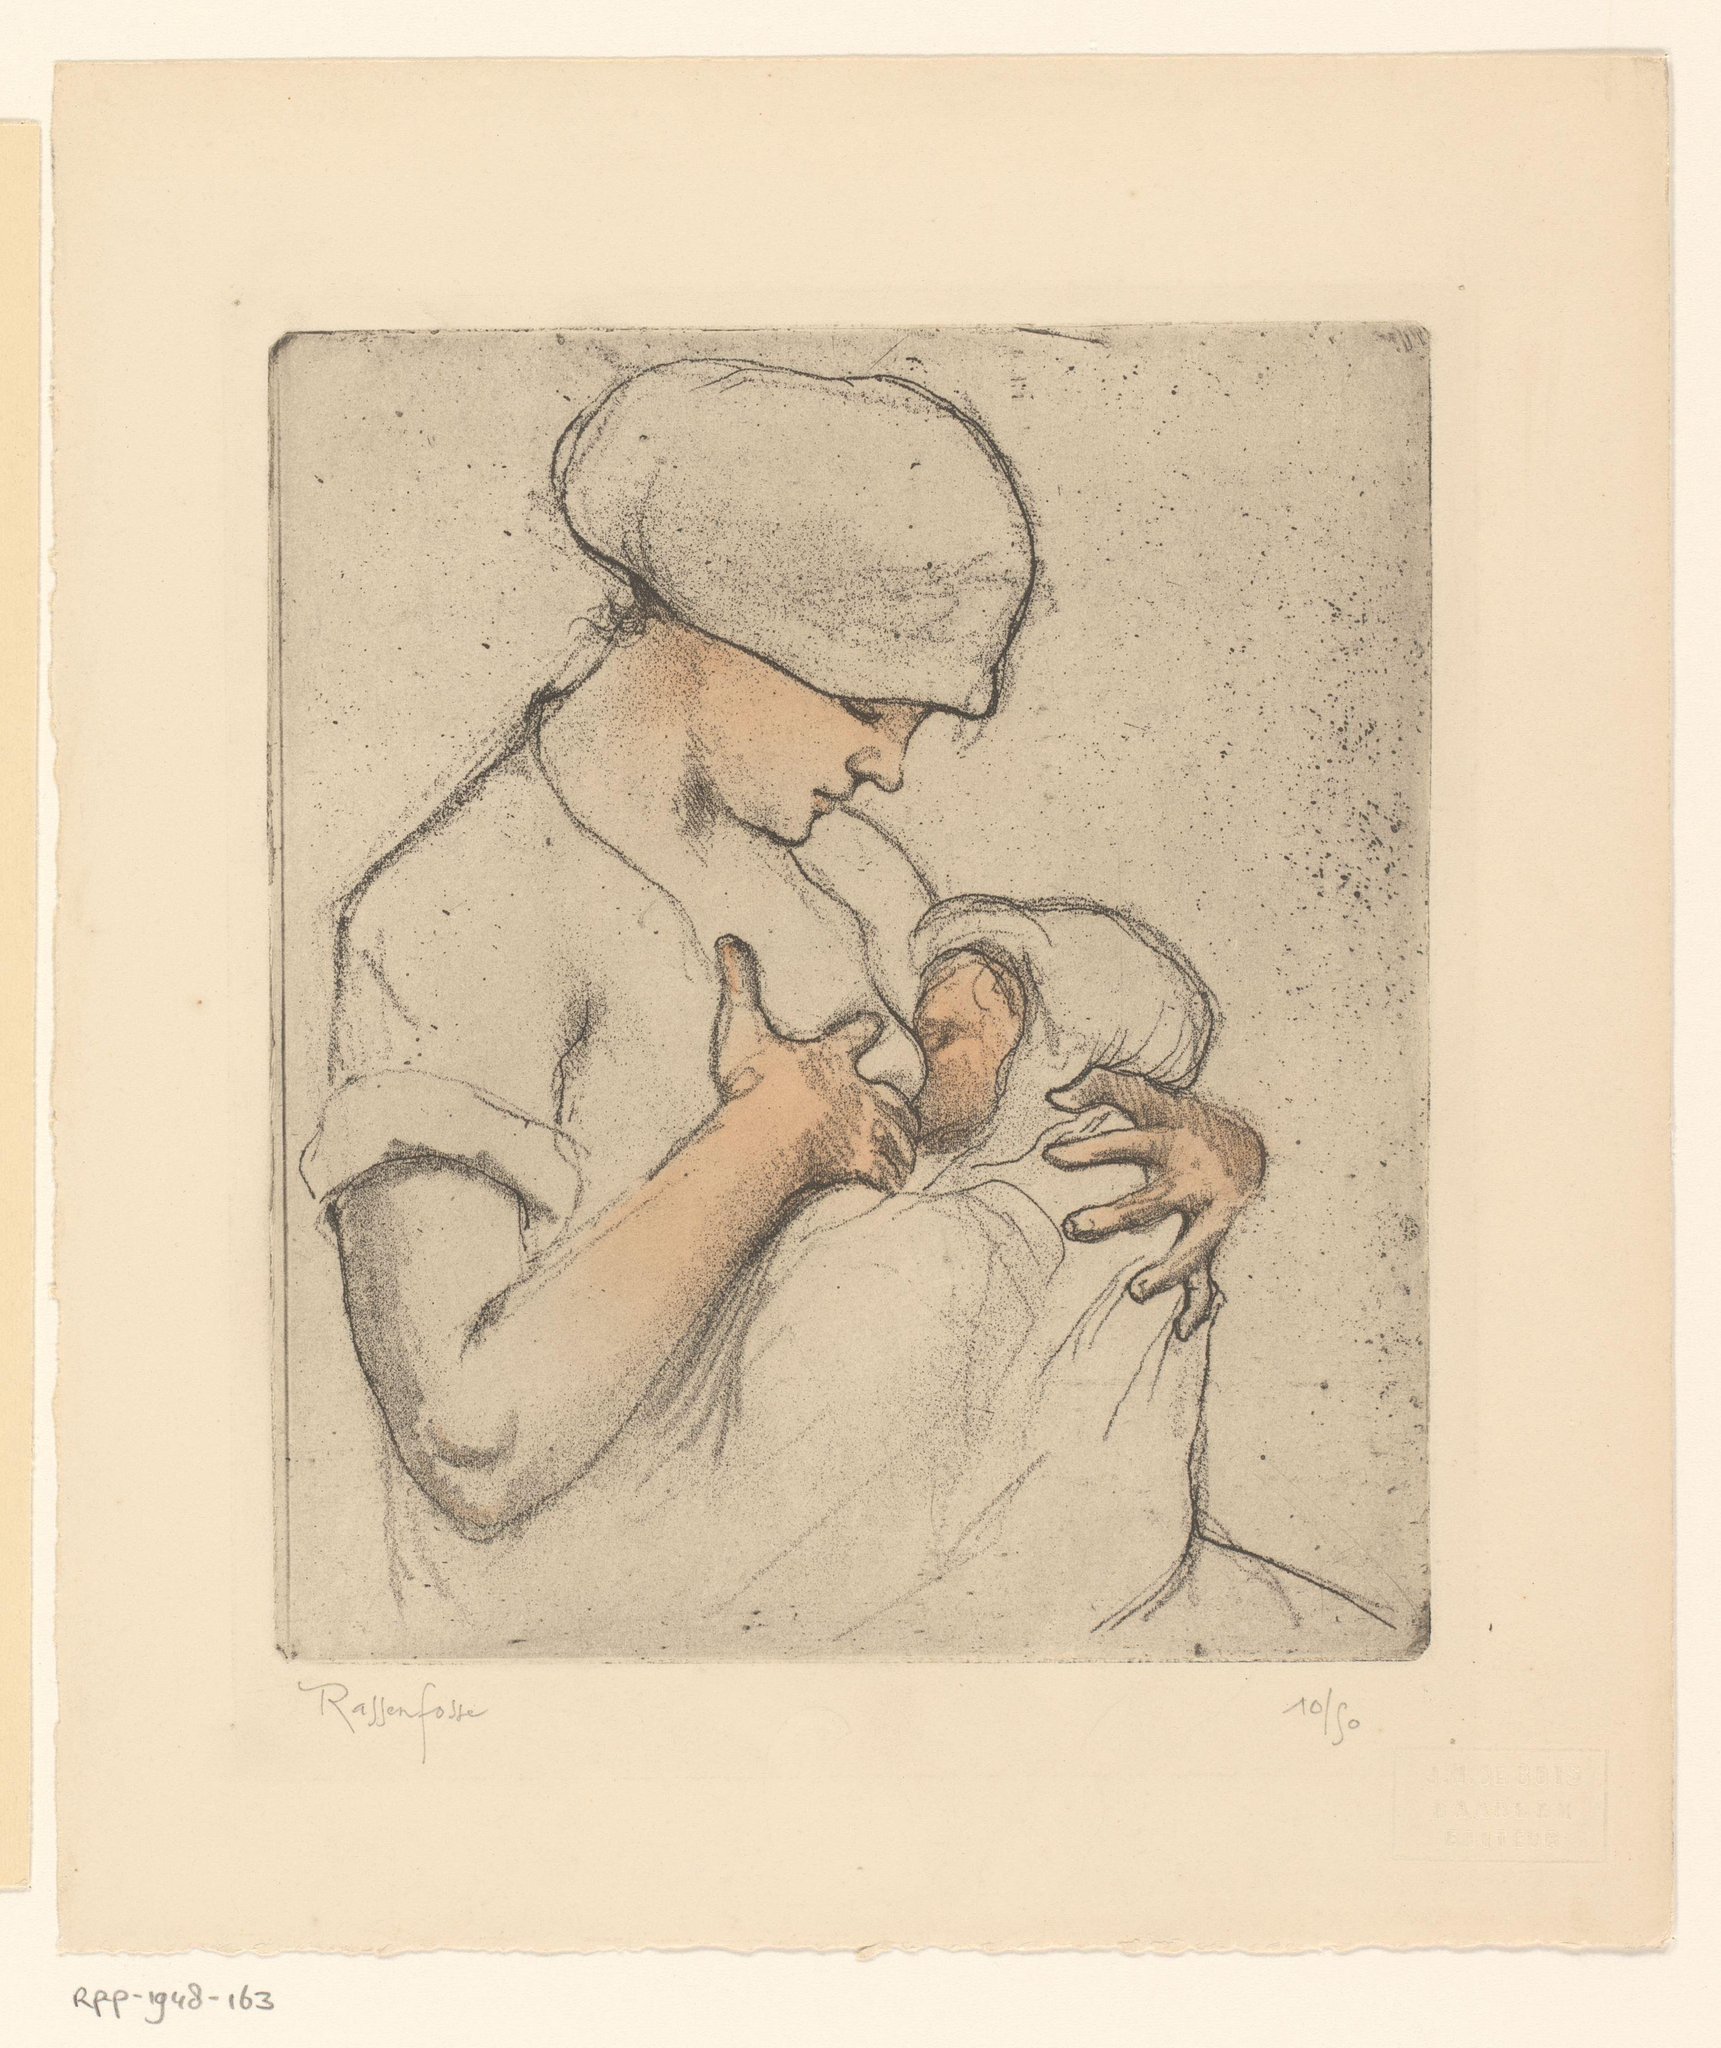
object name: print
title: Vrouw geeft een kind borstvoeding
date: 1918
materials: paper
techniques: hand coloring, intaglio, soft ground etching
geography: haarlem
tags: adolescent, young woman, maiden, feeding a baby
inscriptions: collector's mark: Lugt 2228, check stamp: Lugt 4469, inscription: ‘10/50’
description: Mogelijk gaat het om exemplaar tien van in totaal 50 (Rouir, 1984).